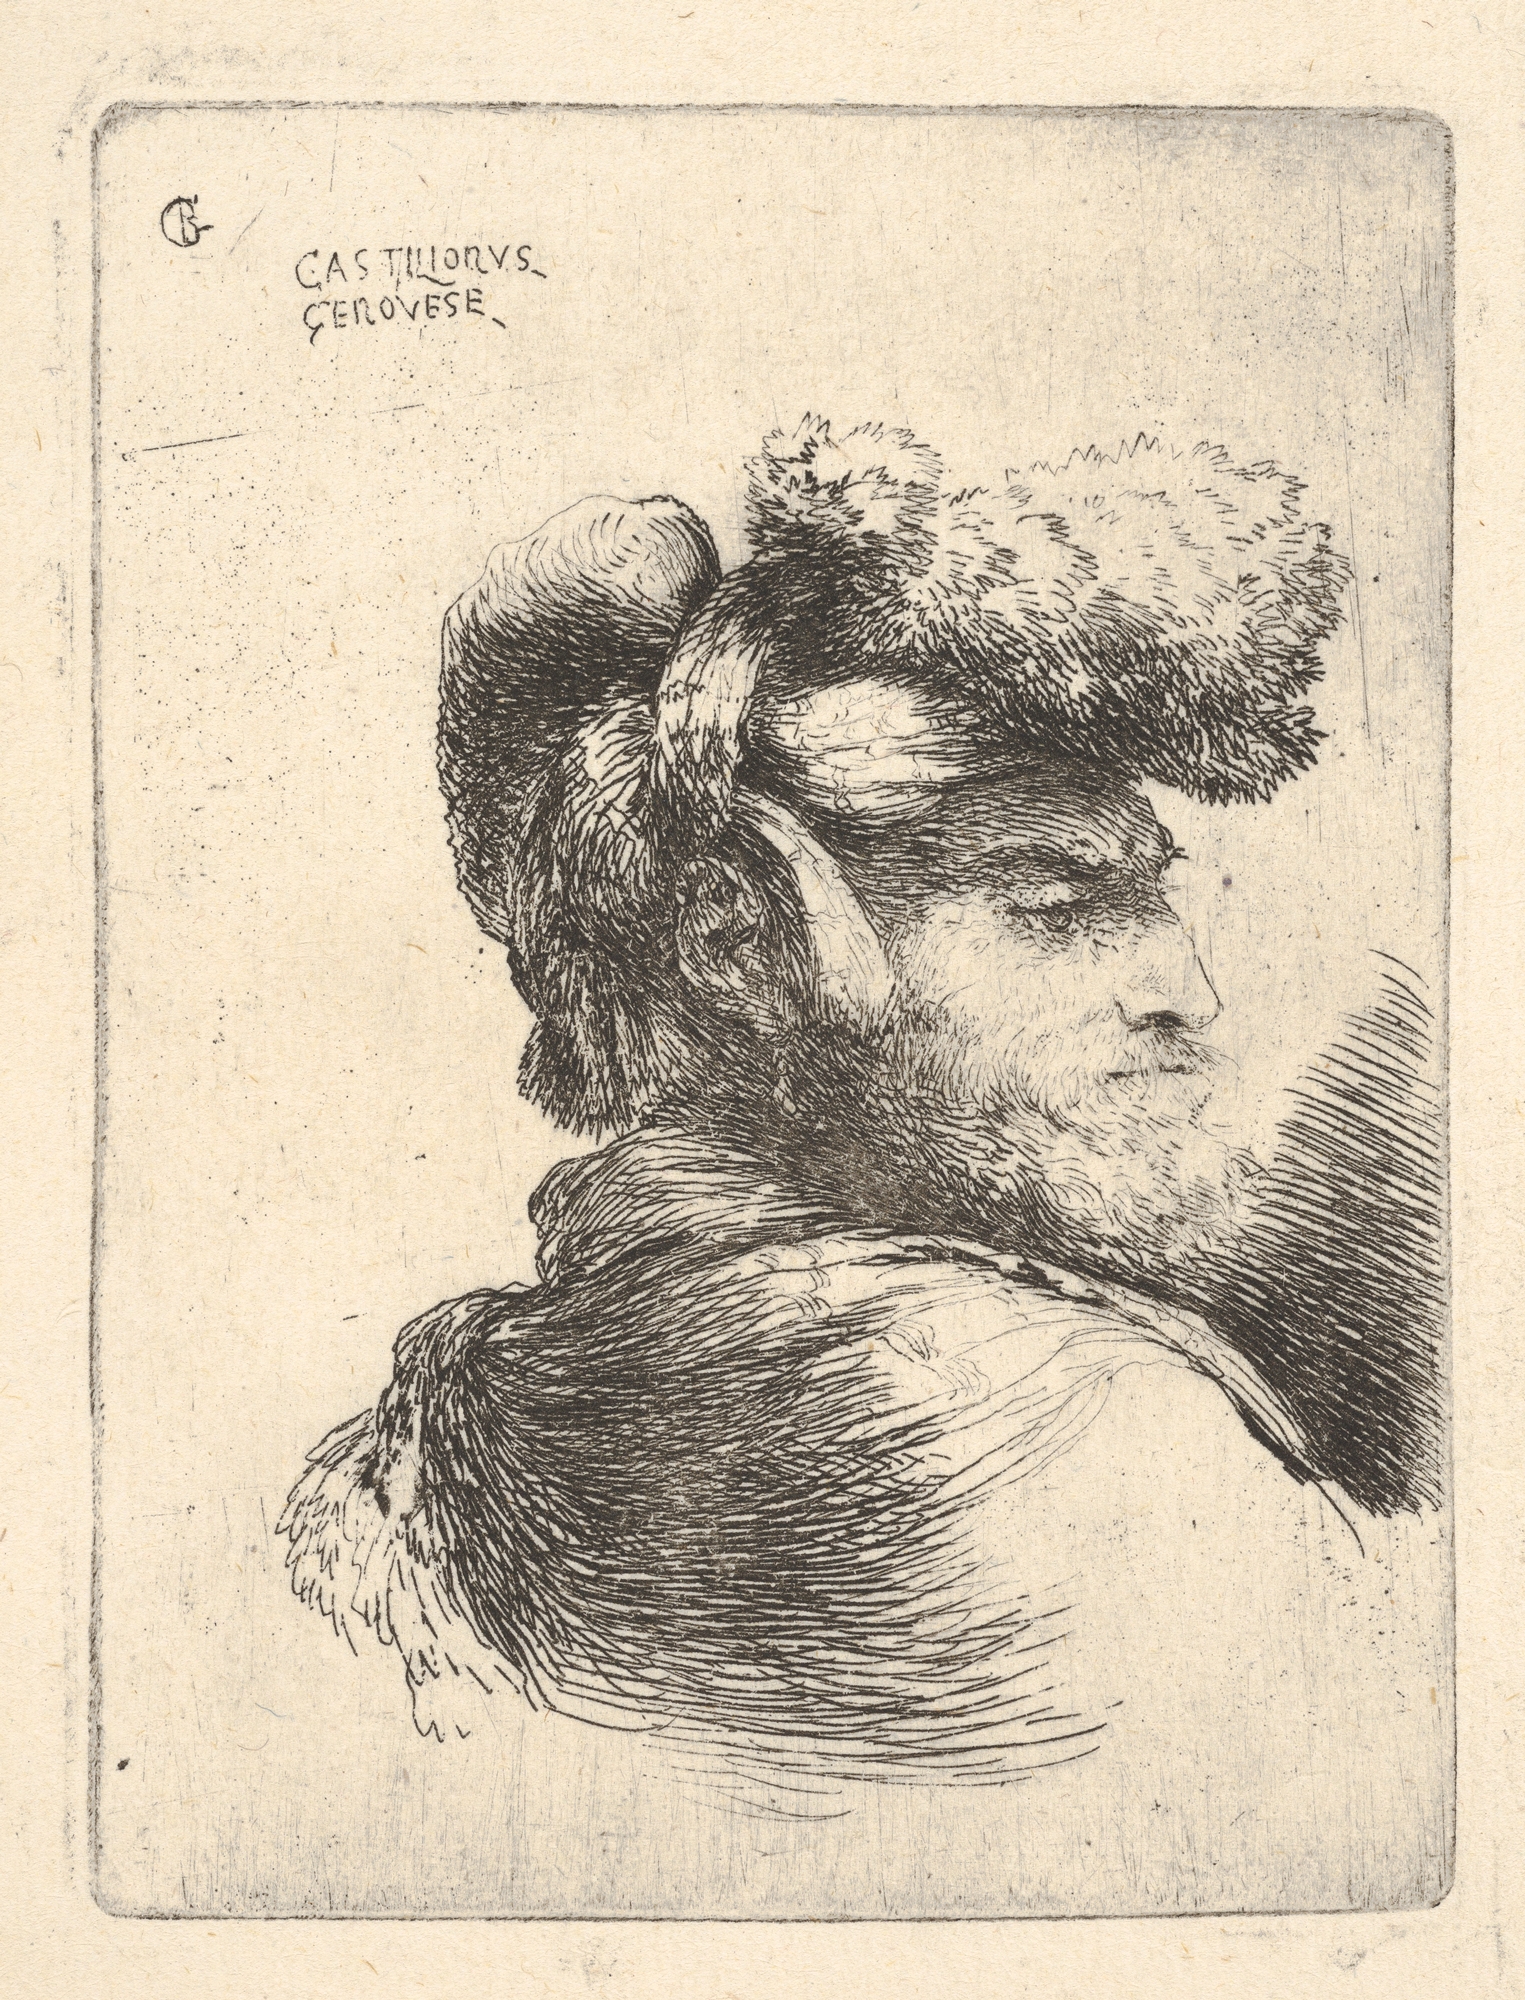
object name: print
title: Man in profile facing right, wearing a fur hat, from "Small Heads in Oriental Headdress"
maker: giovanni benedetto castiglione (il grechetto)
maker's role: artist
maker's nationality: italian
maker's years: 1609-1664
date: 1645-1650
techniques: etching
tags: men,profiles